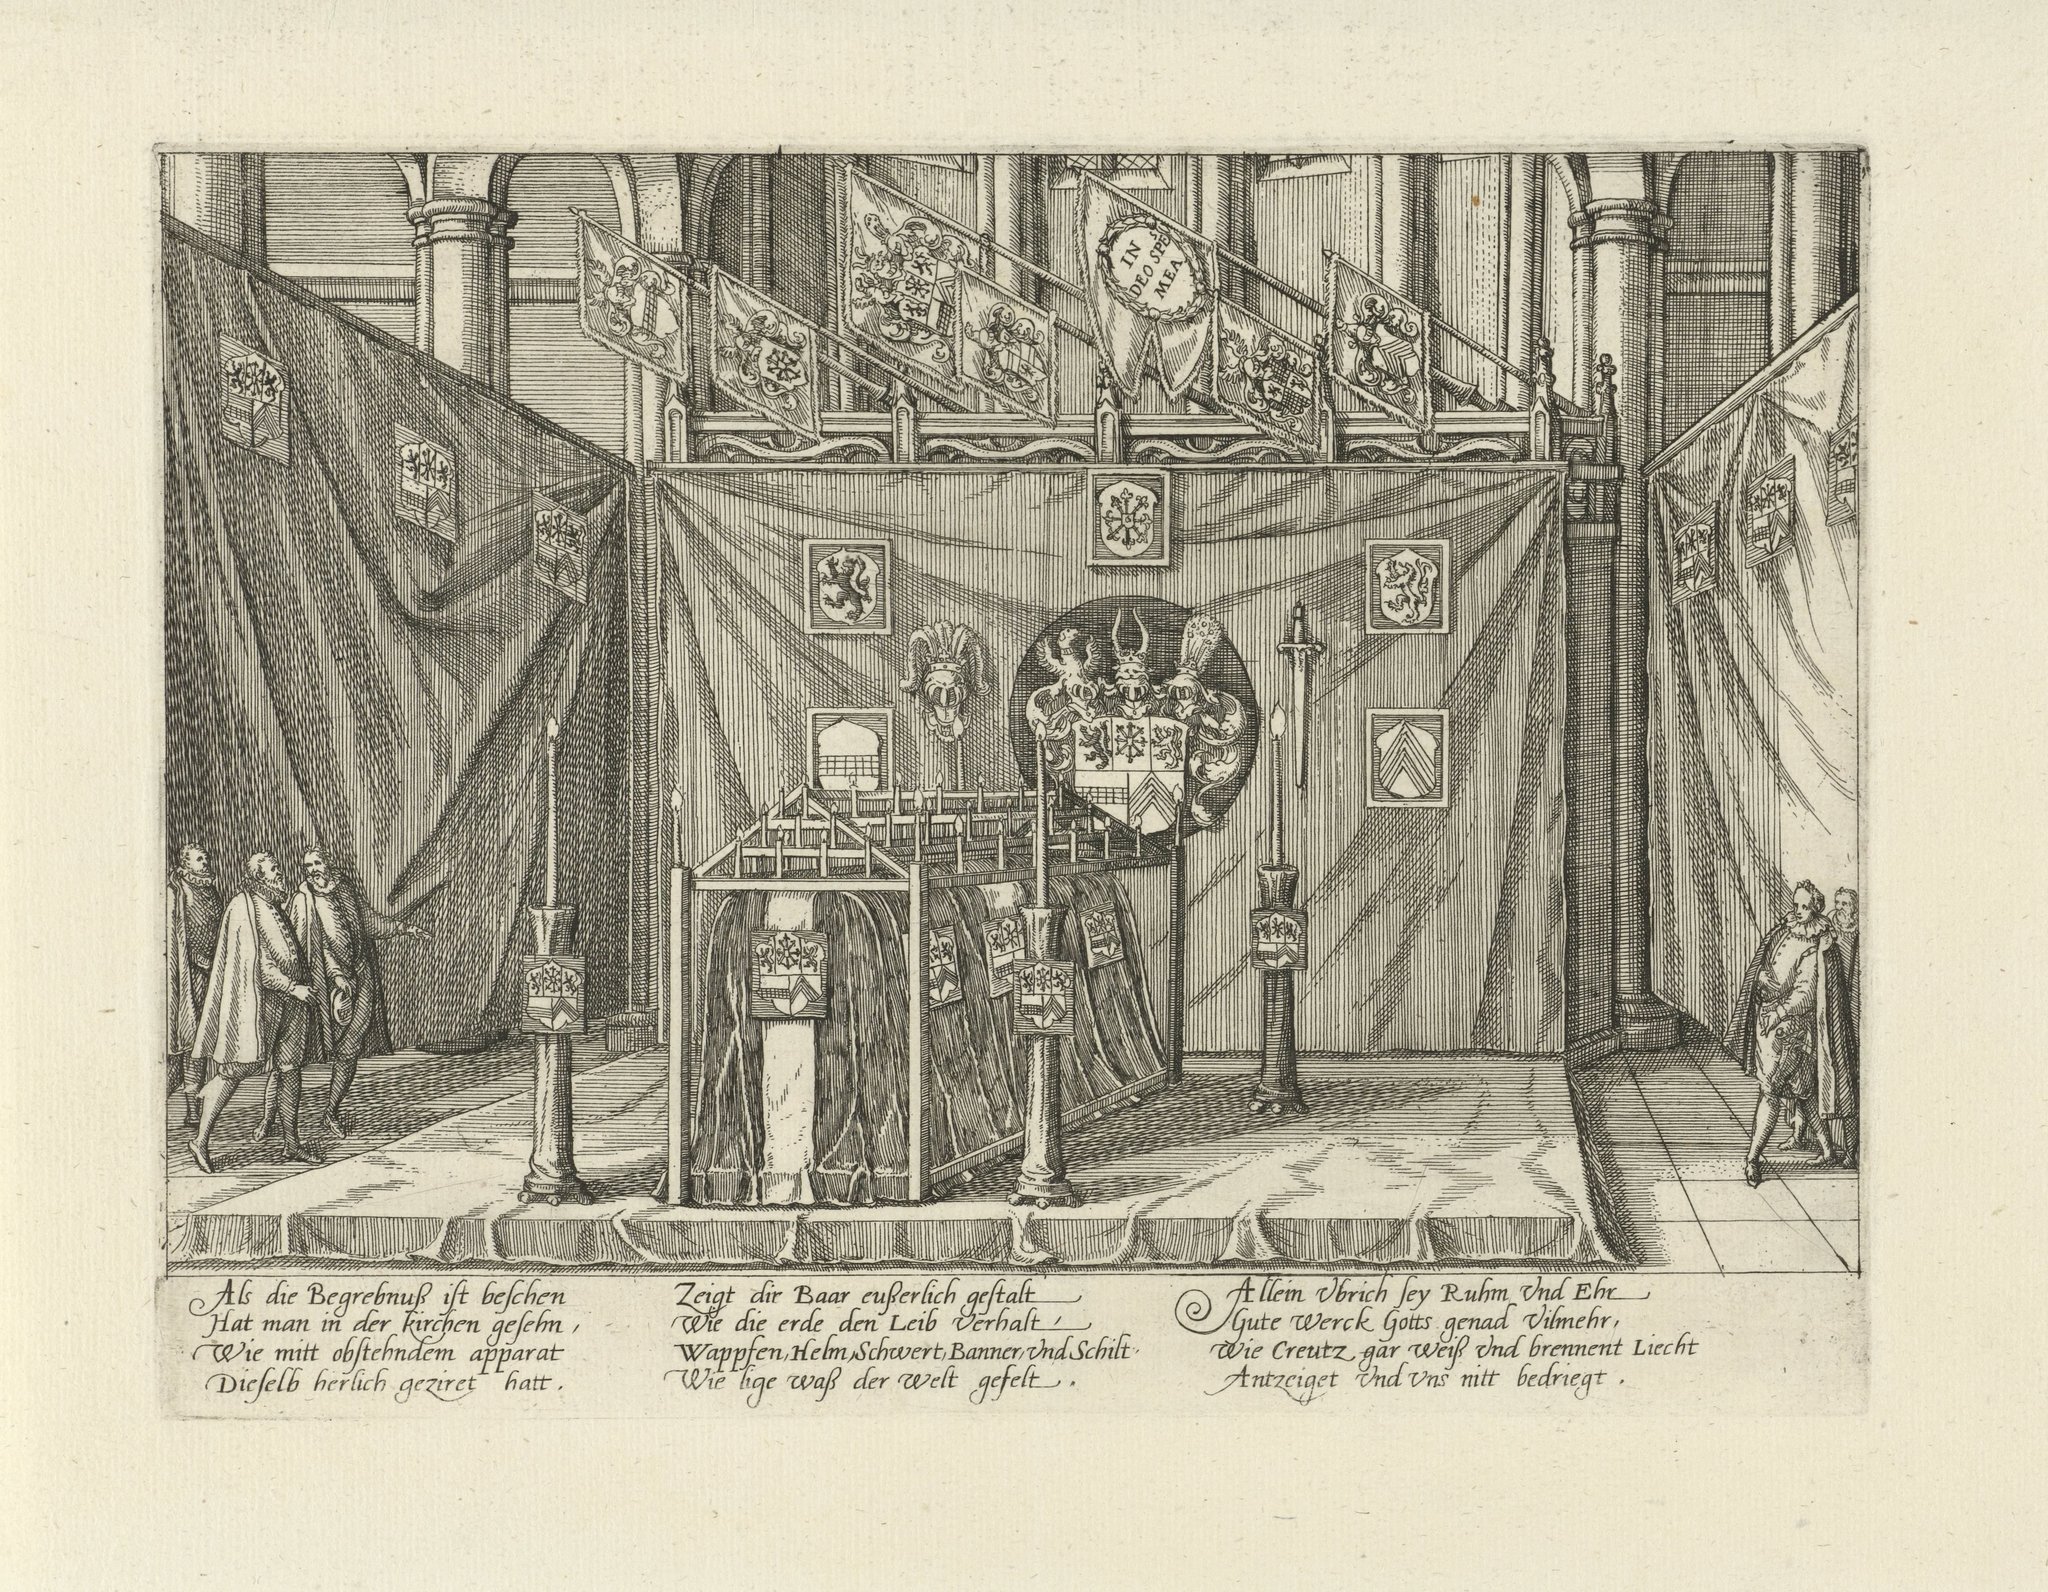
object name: print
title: Spiegel der vergenchlichkeit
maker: Anonymous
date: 1592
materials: paper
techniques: etching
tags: funerary ceremonial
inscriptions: collector's mark: Lugt 2228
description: Prent ook gebruikt in: Graminaeus, Theodor. Spiegel vnd abbildung der Vergengligkeit: Darinnen was der Toden Recht vnd Geburnuß begriffen ... Vnd wie der Durchleuchtiger ... Herr Johan Wilhelm Hertzog zu Gülich, Cleue vnd Berg ... da jhr F.G. Herr Vatter Christmilter gedechtnuß, Hertzog Wilhelm ... im Jahr 1592. ... entschlaffen, ... am zehenden Tag Martij in der Collegiat Kirchen zu Düsseldorff ... begraben ... lassen. Keulen: Theodor Graminaeus, 1592.